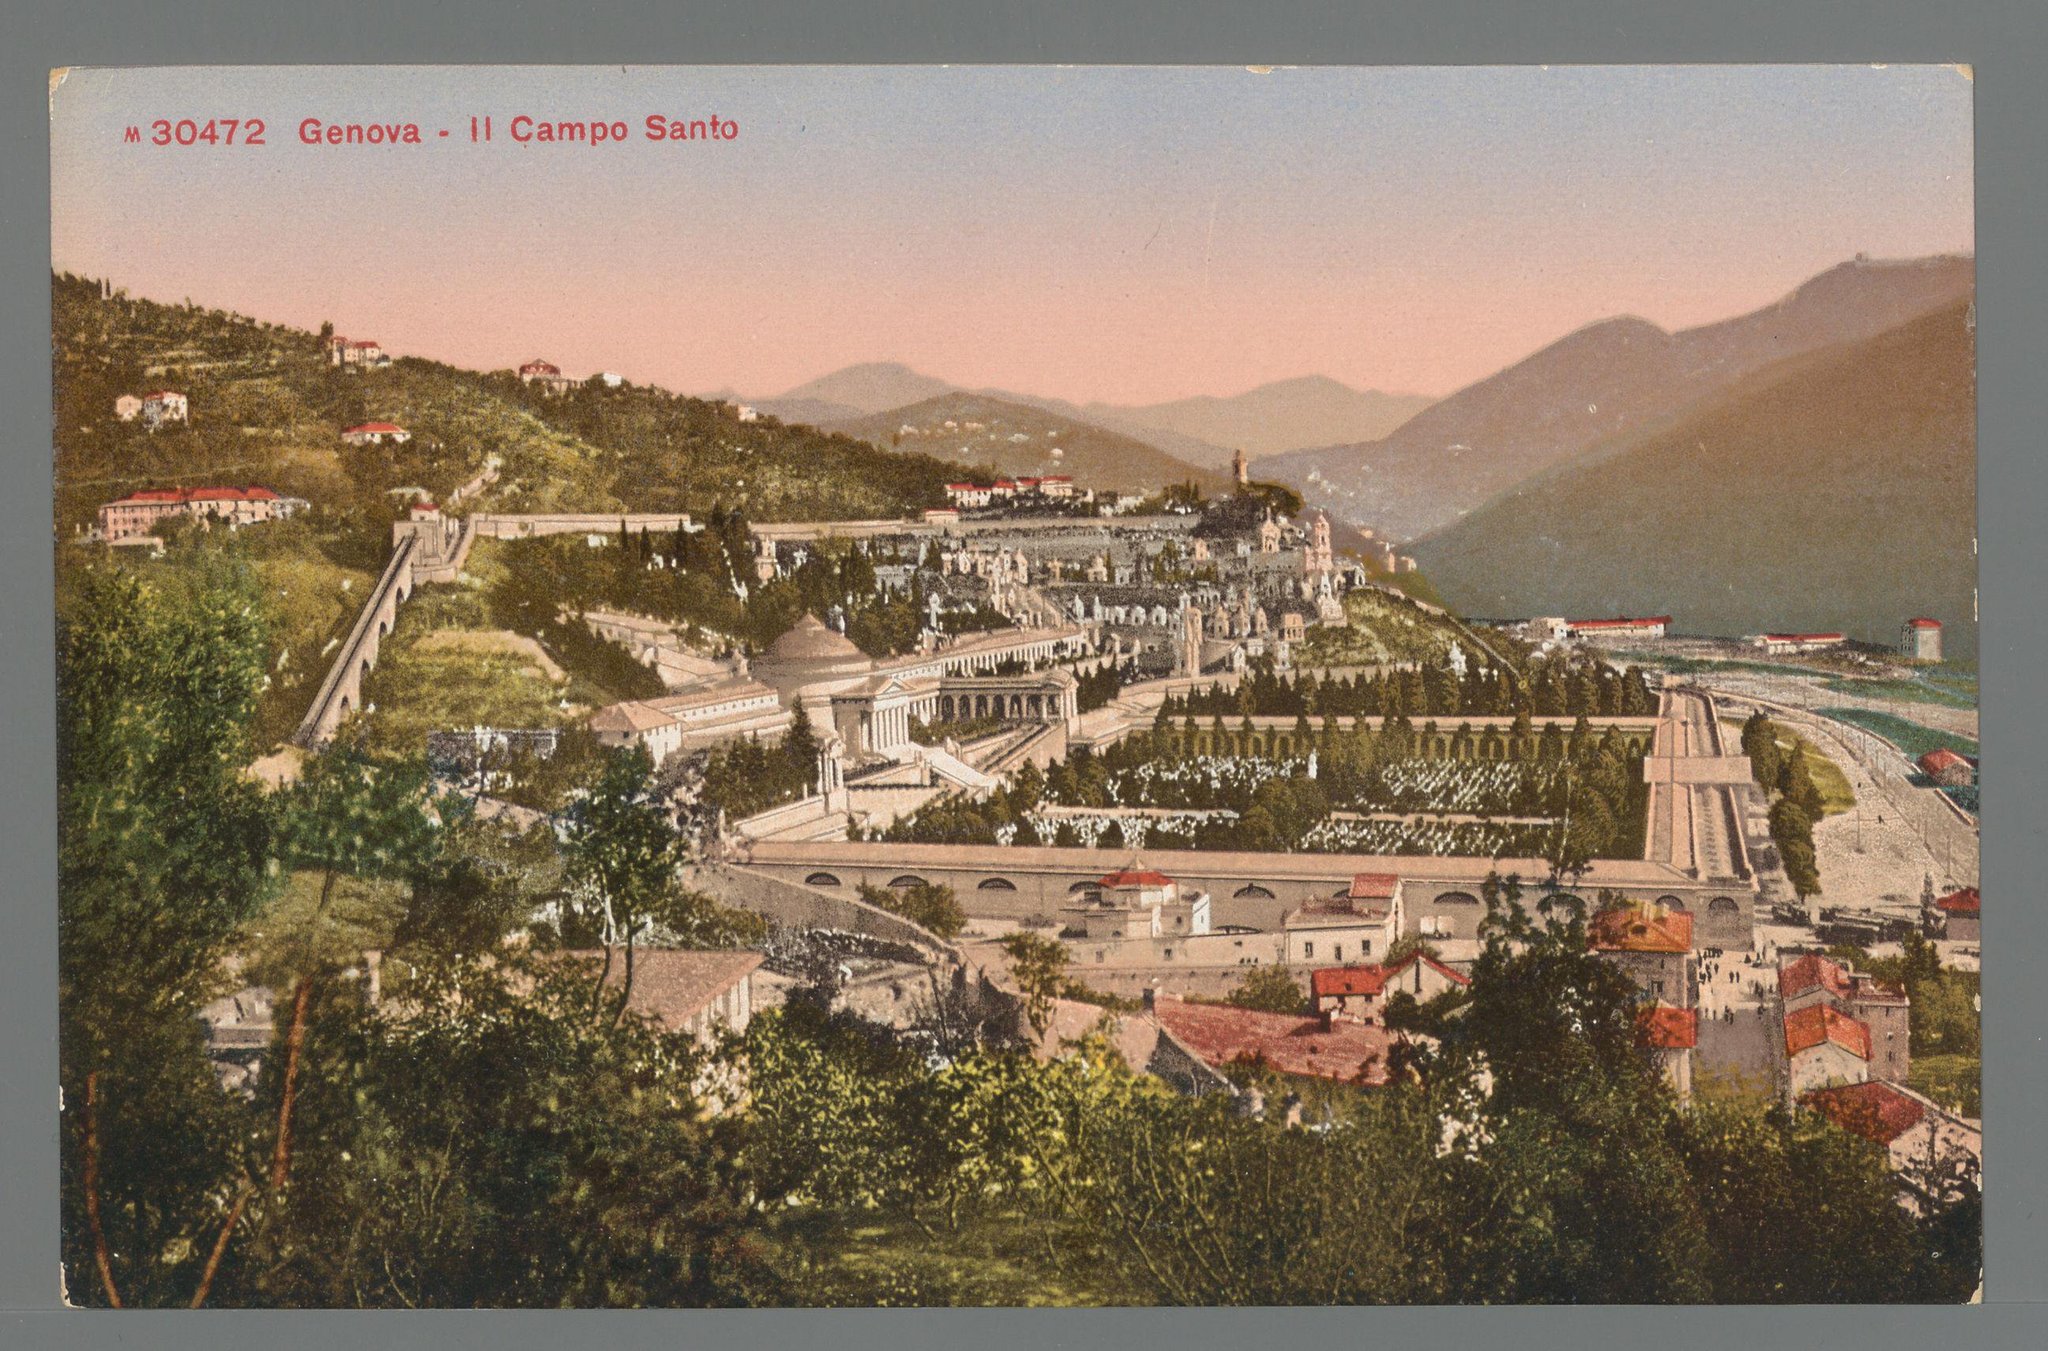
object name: photomechanical print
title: Genova. Il Campo Santo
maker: Anonymous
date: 1905-1930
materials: cardboard, photographic process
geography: genoa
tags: cemetery, park-like burying ground, mountains